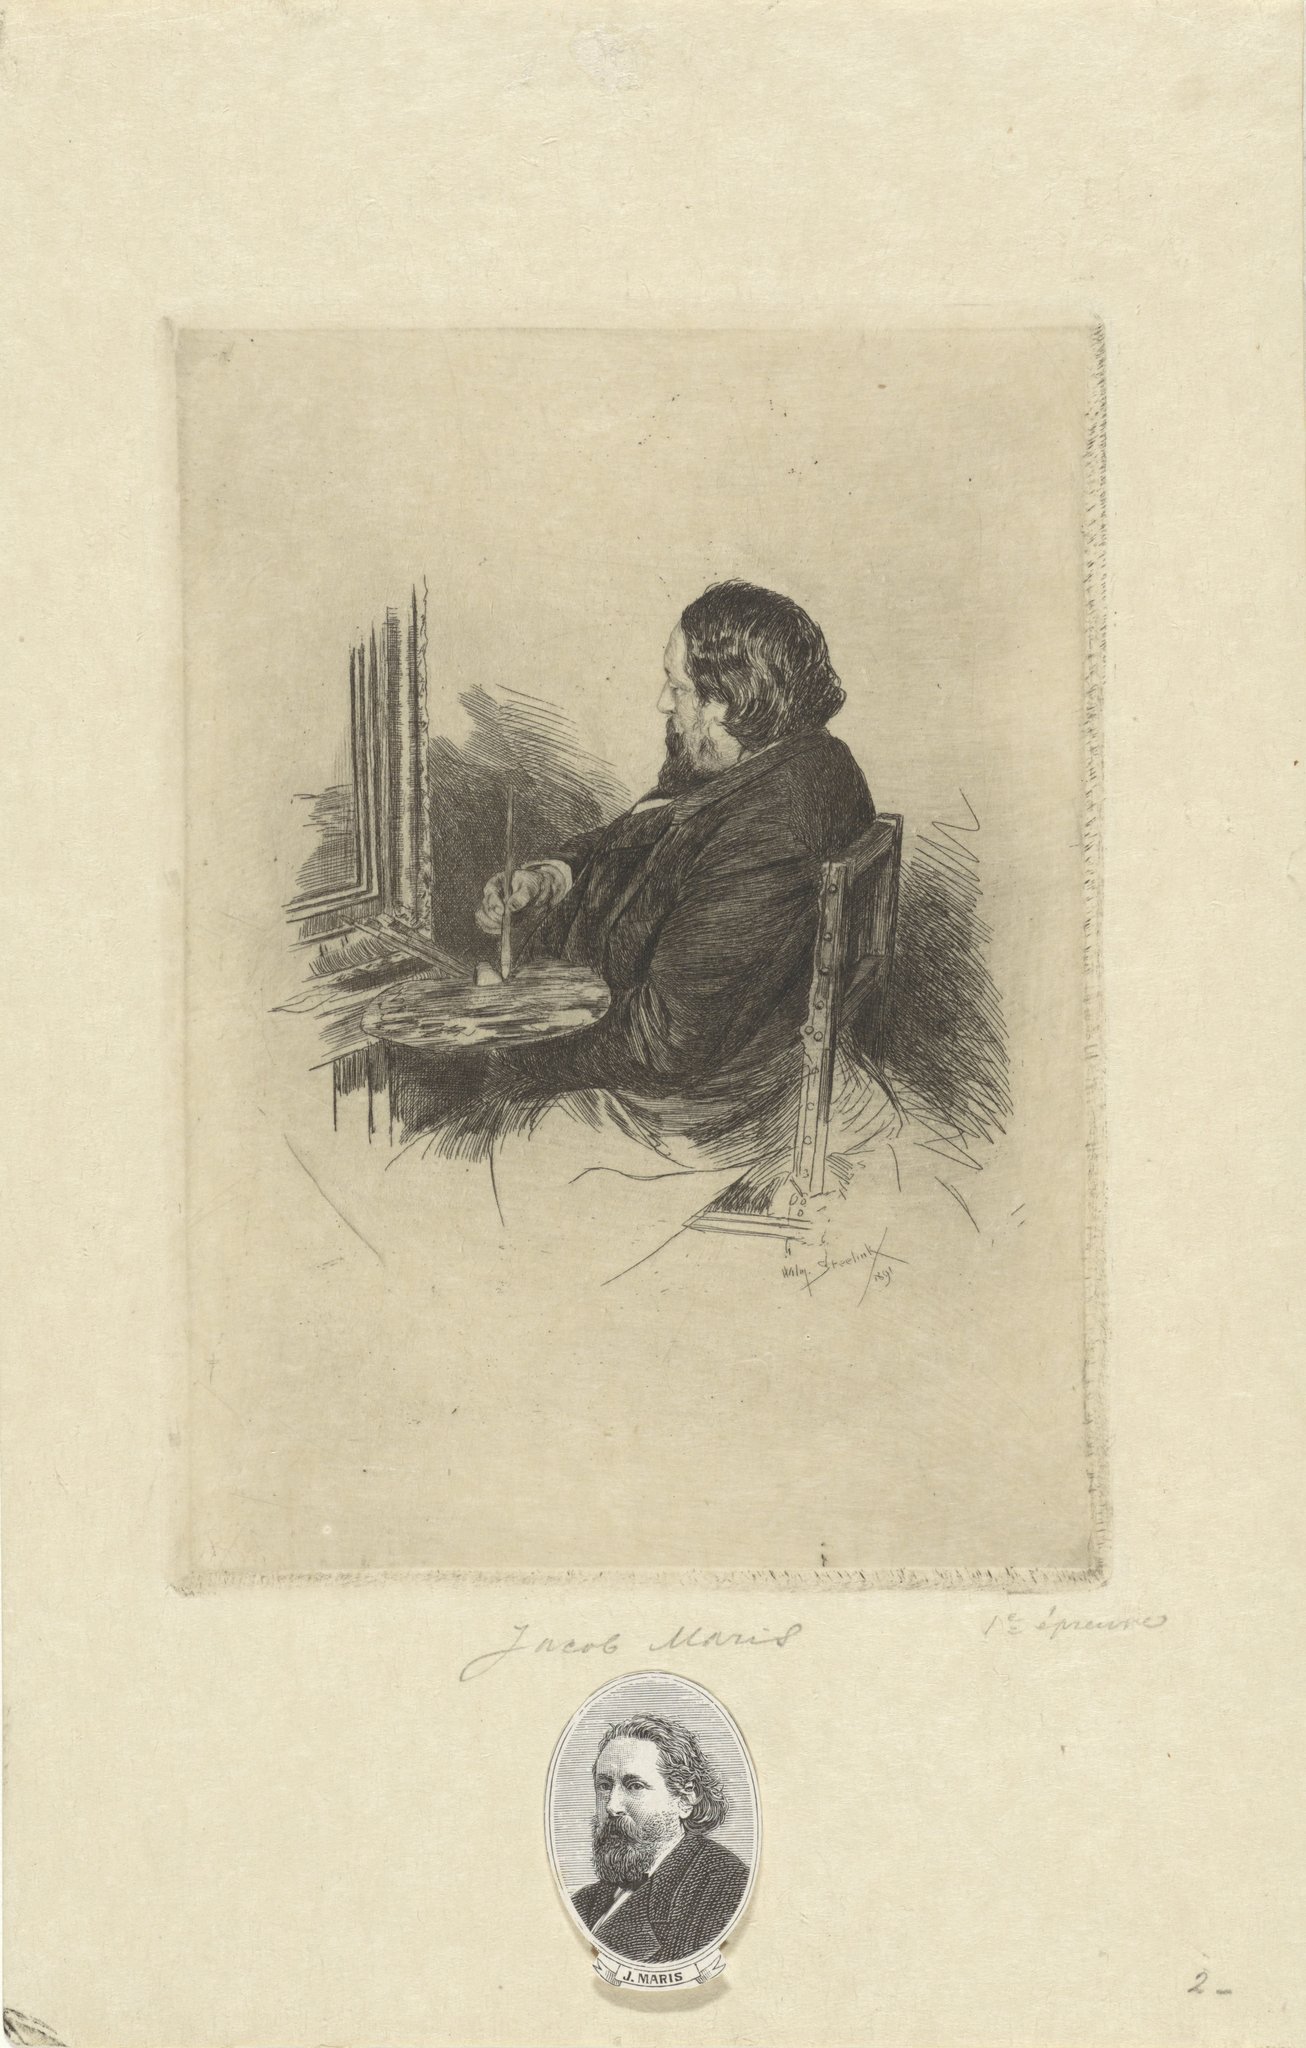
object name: print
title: Portret van Jacob Maris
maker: willem steelink (ii)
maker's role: draughtsman, print maker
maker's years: 1856-1928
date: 1891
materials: paper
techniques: etching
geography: netherlands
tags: the hague, draughtsman, jacob maris, portrait, self-portrait of painter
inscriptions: collector's mark: Lugt 2760, inscription: ‘Jacob Maris 1e épreuve’, collector's mark: Lugt 2228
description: Portret van Jacob Maris, zittend op een stoel met een palet en penseel in zijn handen.